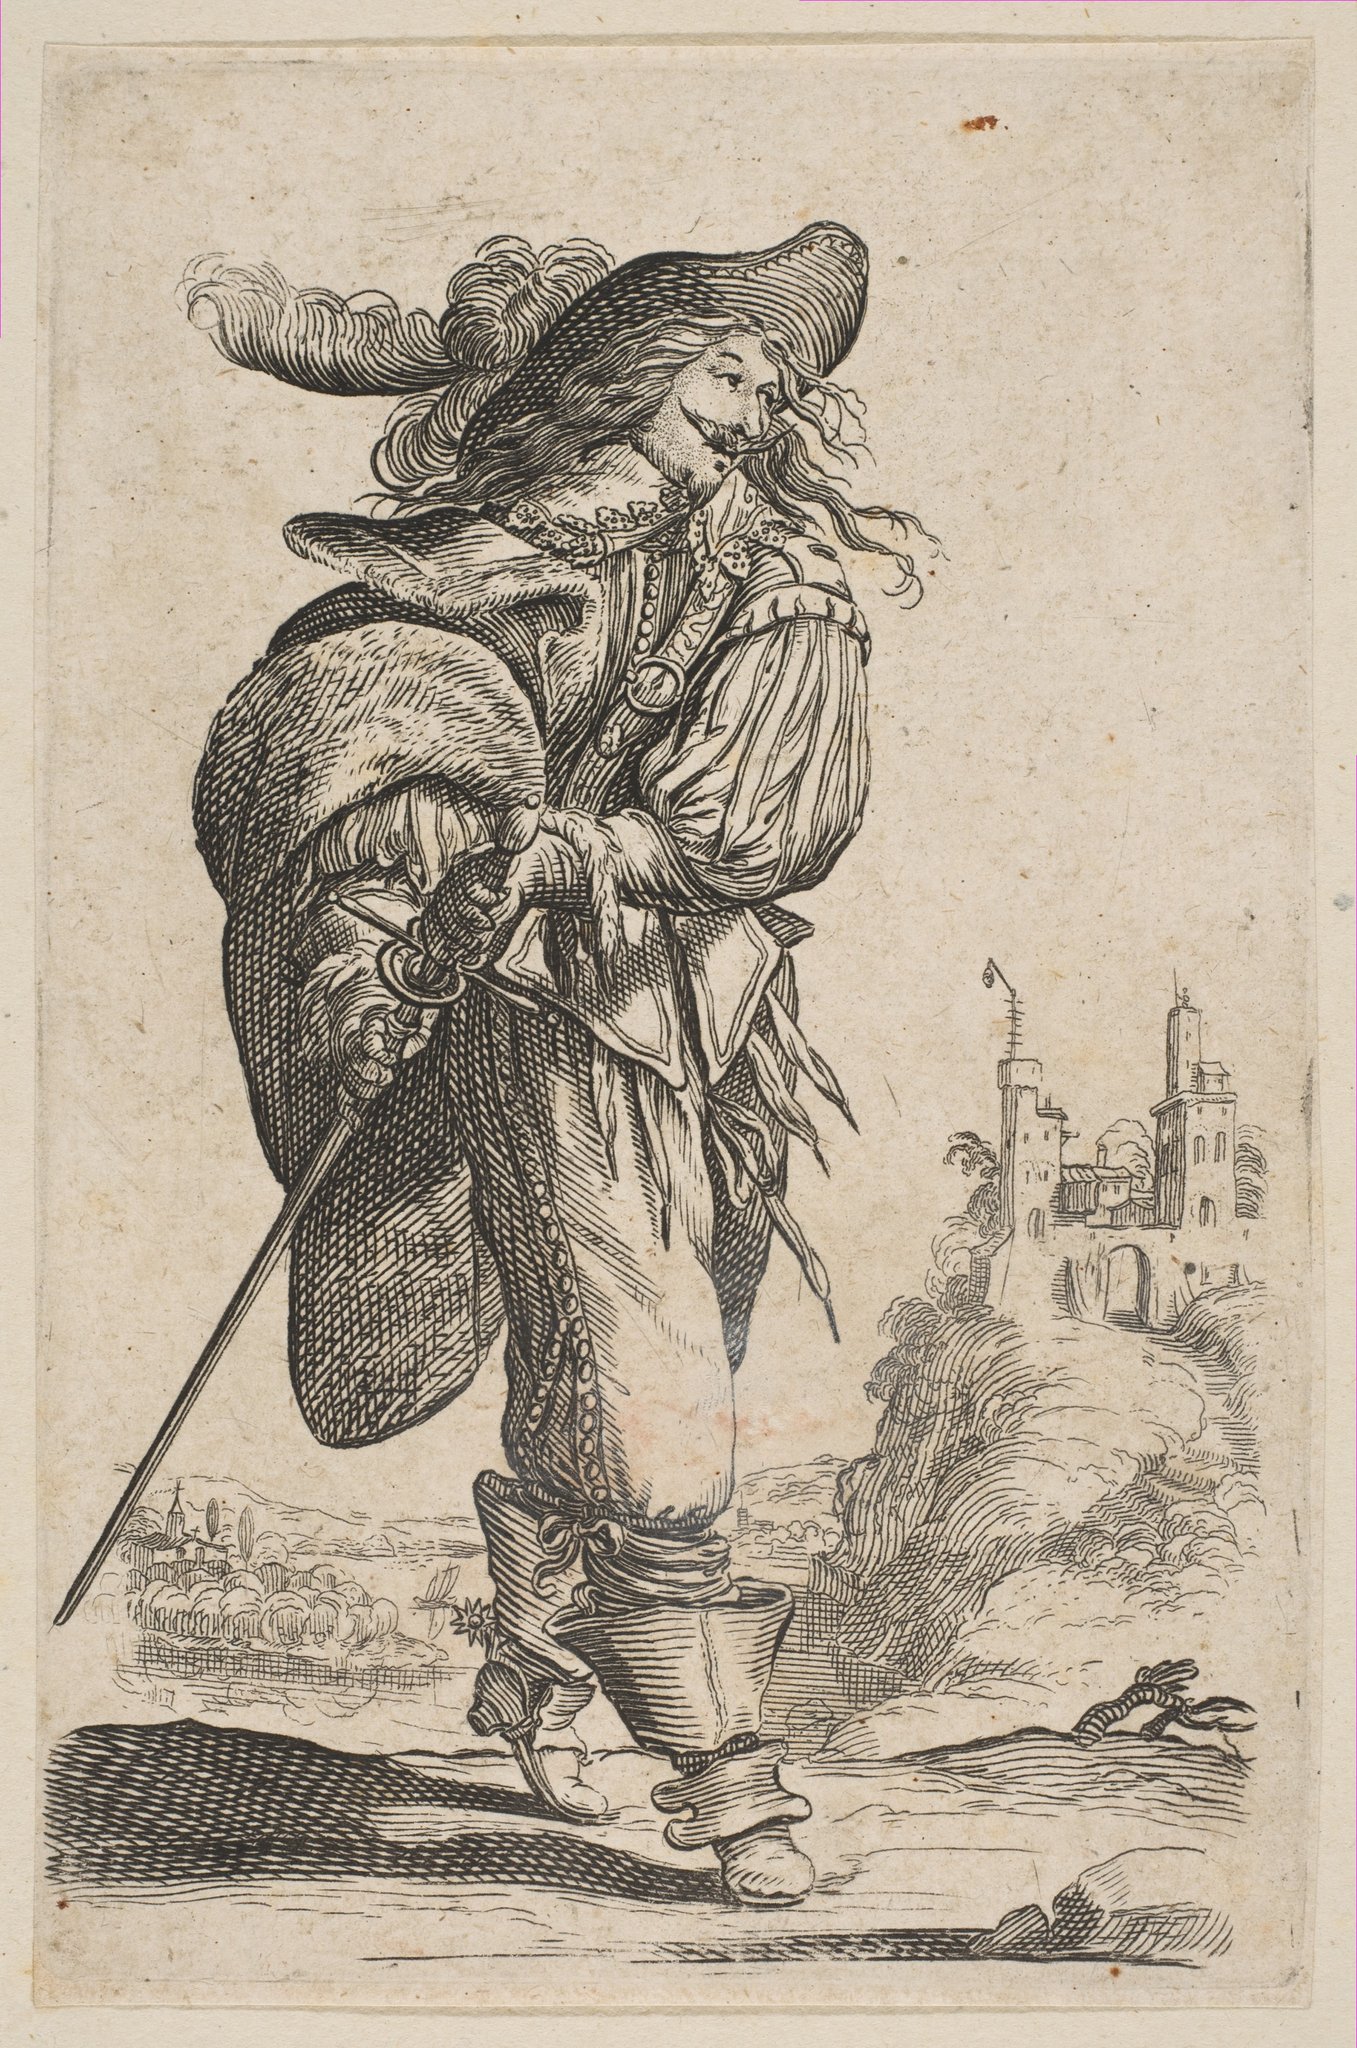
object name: print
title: Gentleman Holding a Sword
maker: anonymous, french, 17th century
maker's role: artist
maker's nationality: french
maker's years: 1600-1700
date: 1629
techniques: etching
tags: swords,men